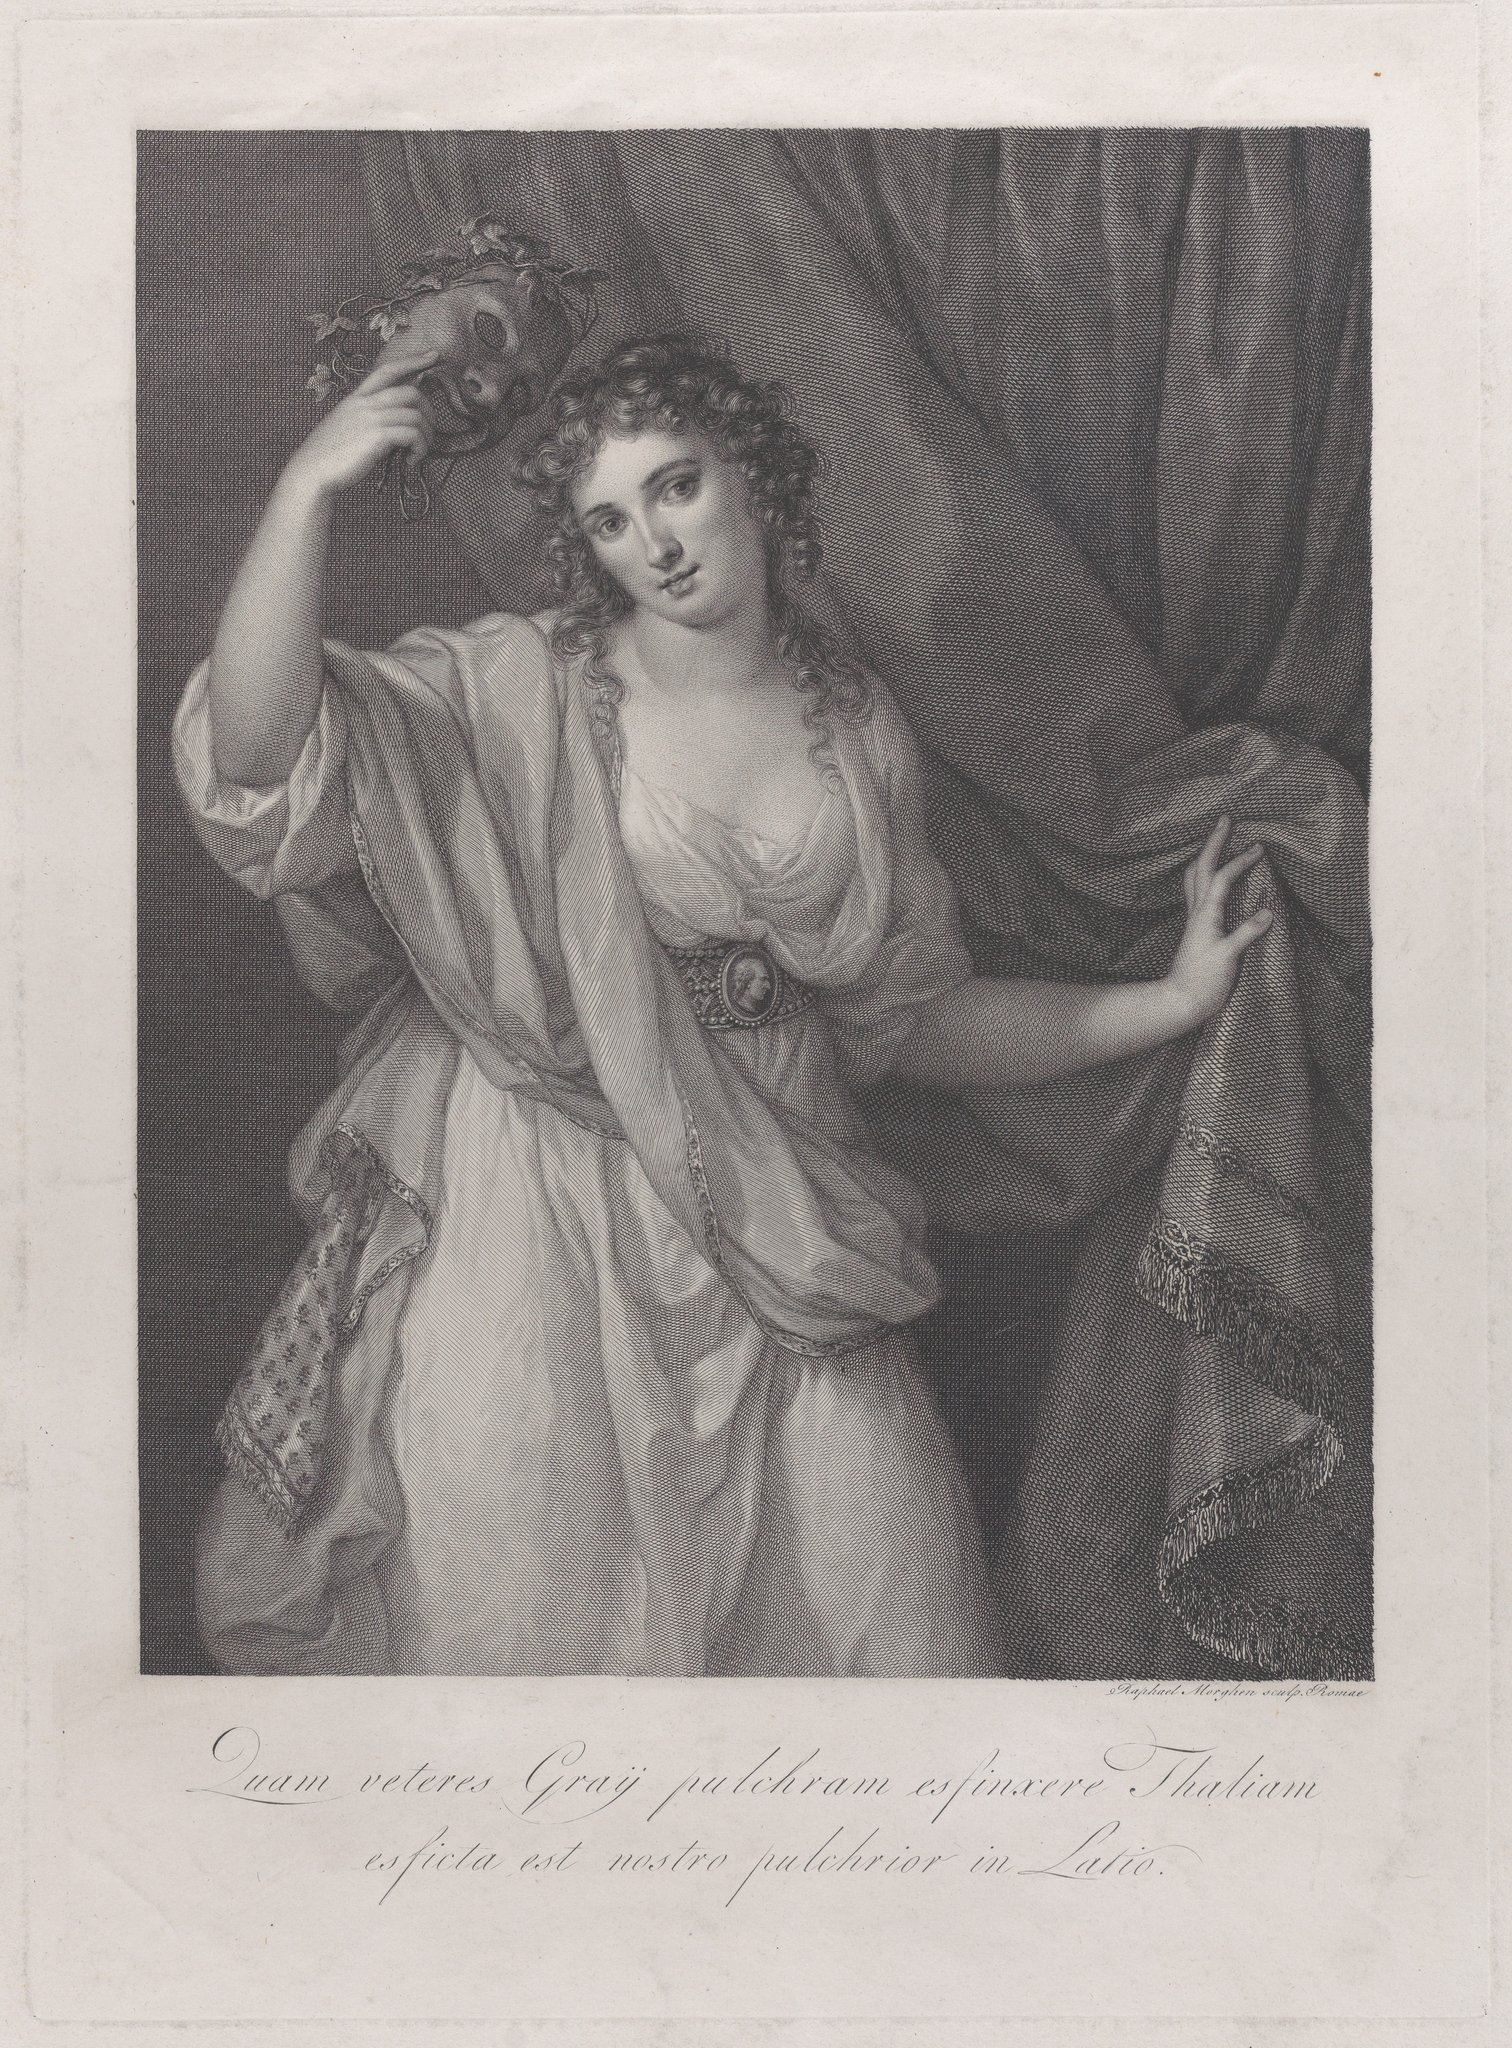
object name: print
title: Lady Hamilton as the Comic Muse, Thalia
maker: raphael morghen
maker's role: artist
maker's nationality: italian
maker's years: 1758-1833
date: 1791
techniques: engraving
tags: portraits,women,actresses